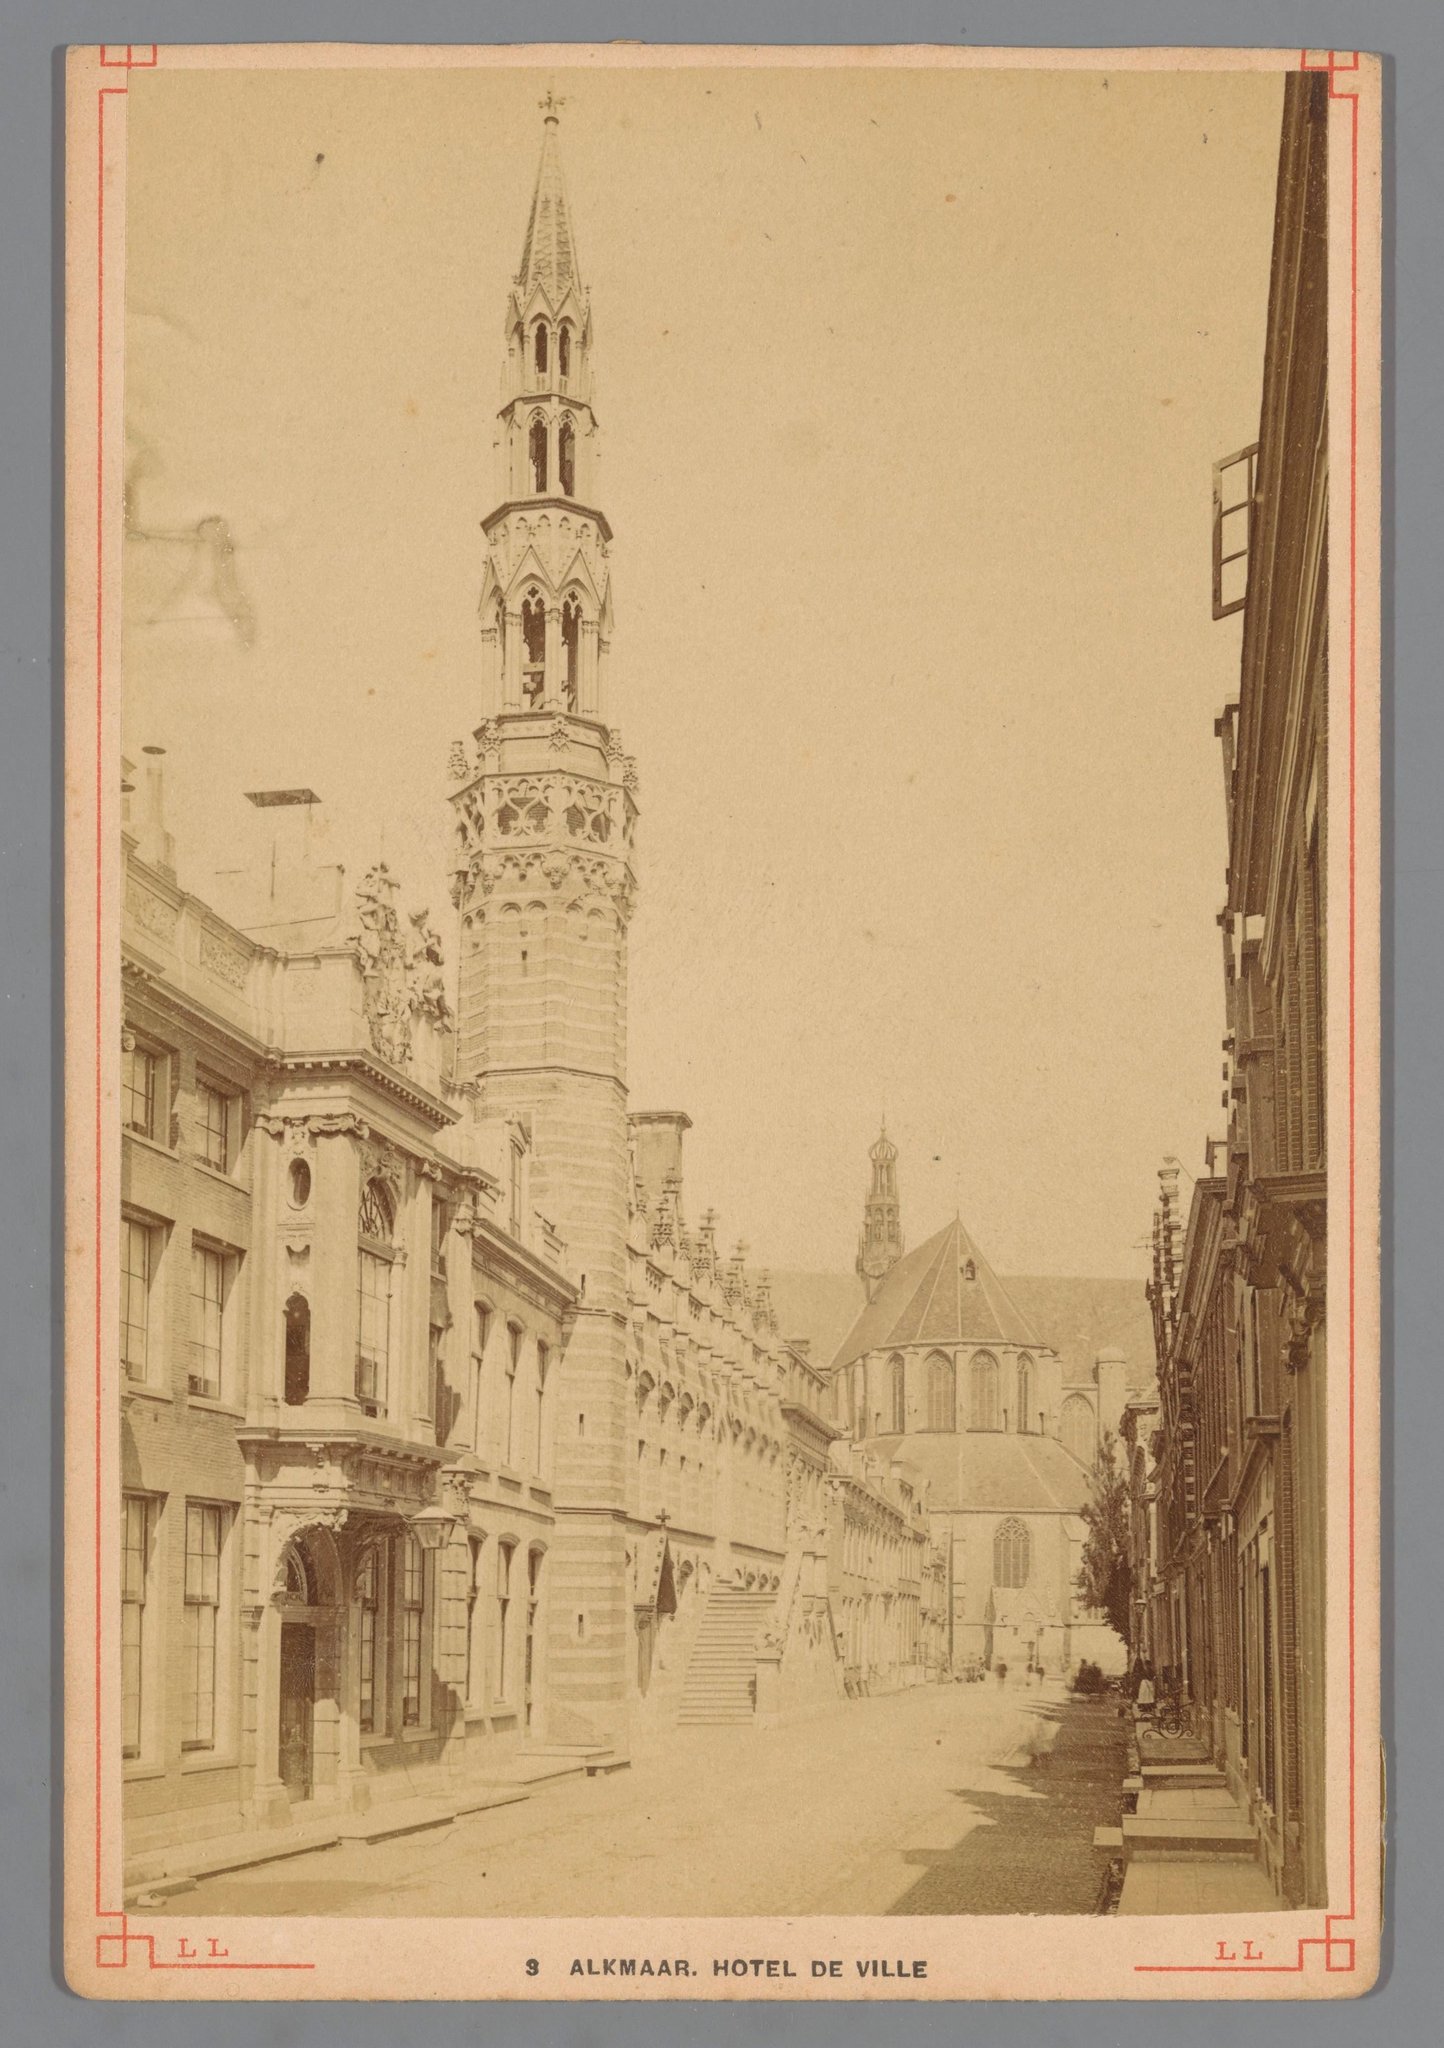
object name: cabinet photograph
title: Alkmaar, Hotel de Ville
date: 1864-1900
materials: cardboard, photographic support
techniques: albumen print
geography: alkmaar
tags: townhall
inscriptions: number: ‘3’, retailer's mark: ‘J. N. PLEMPER van BALEN/ BOEK- & MUZIEKHANDEL/ ALKMAAR’